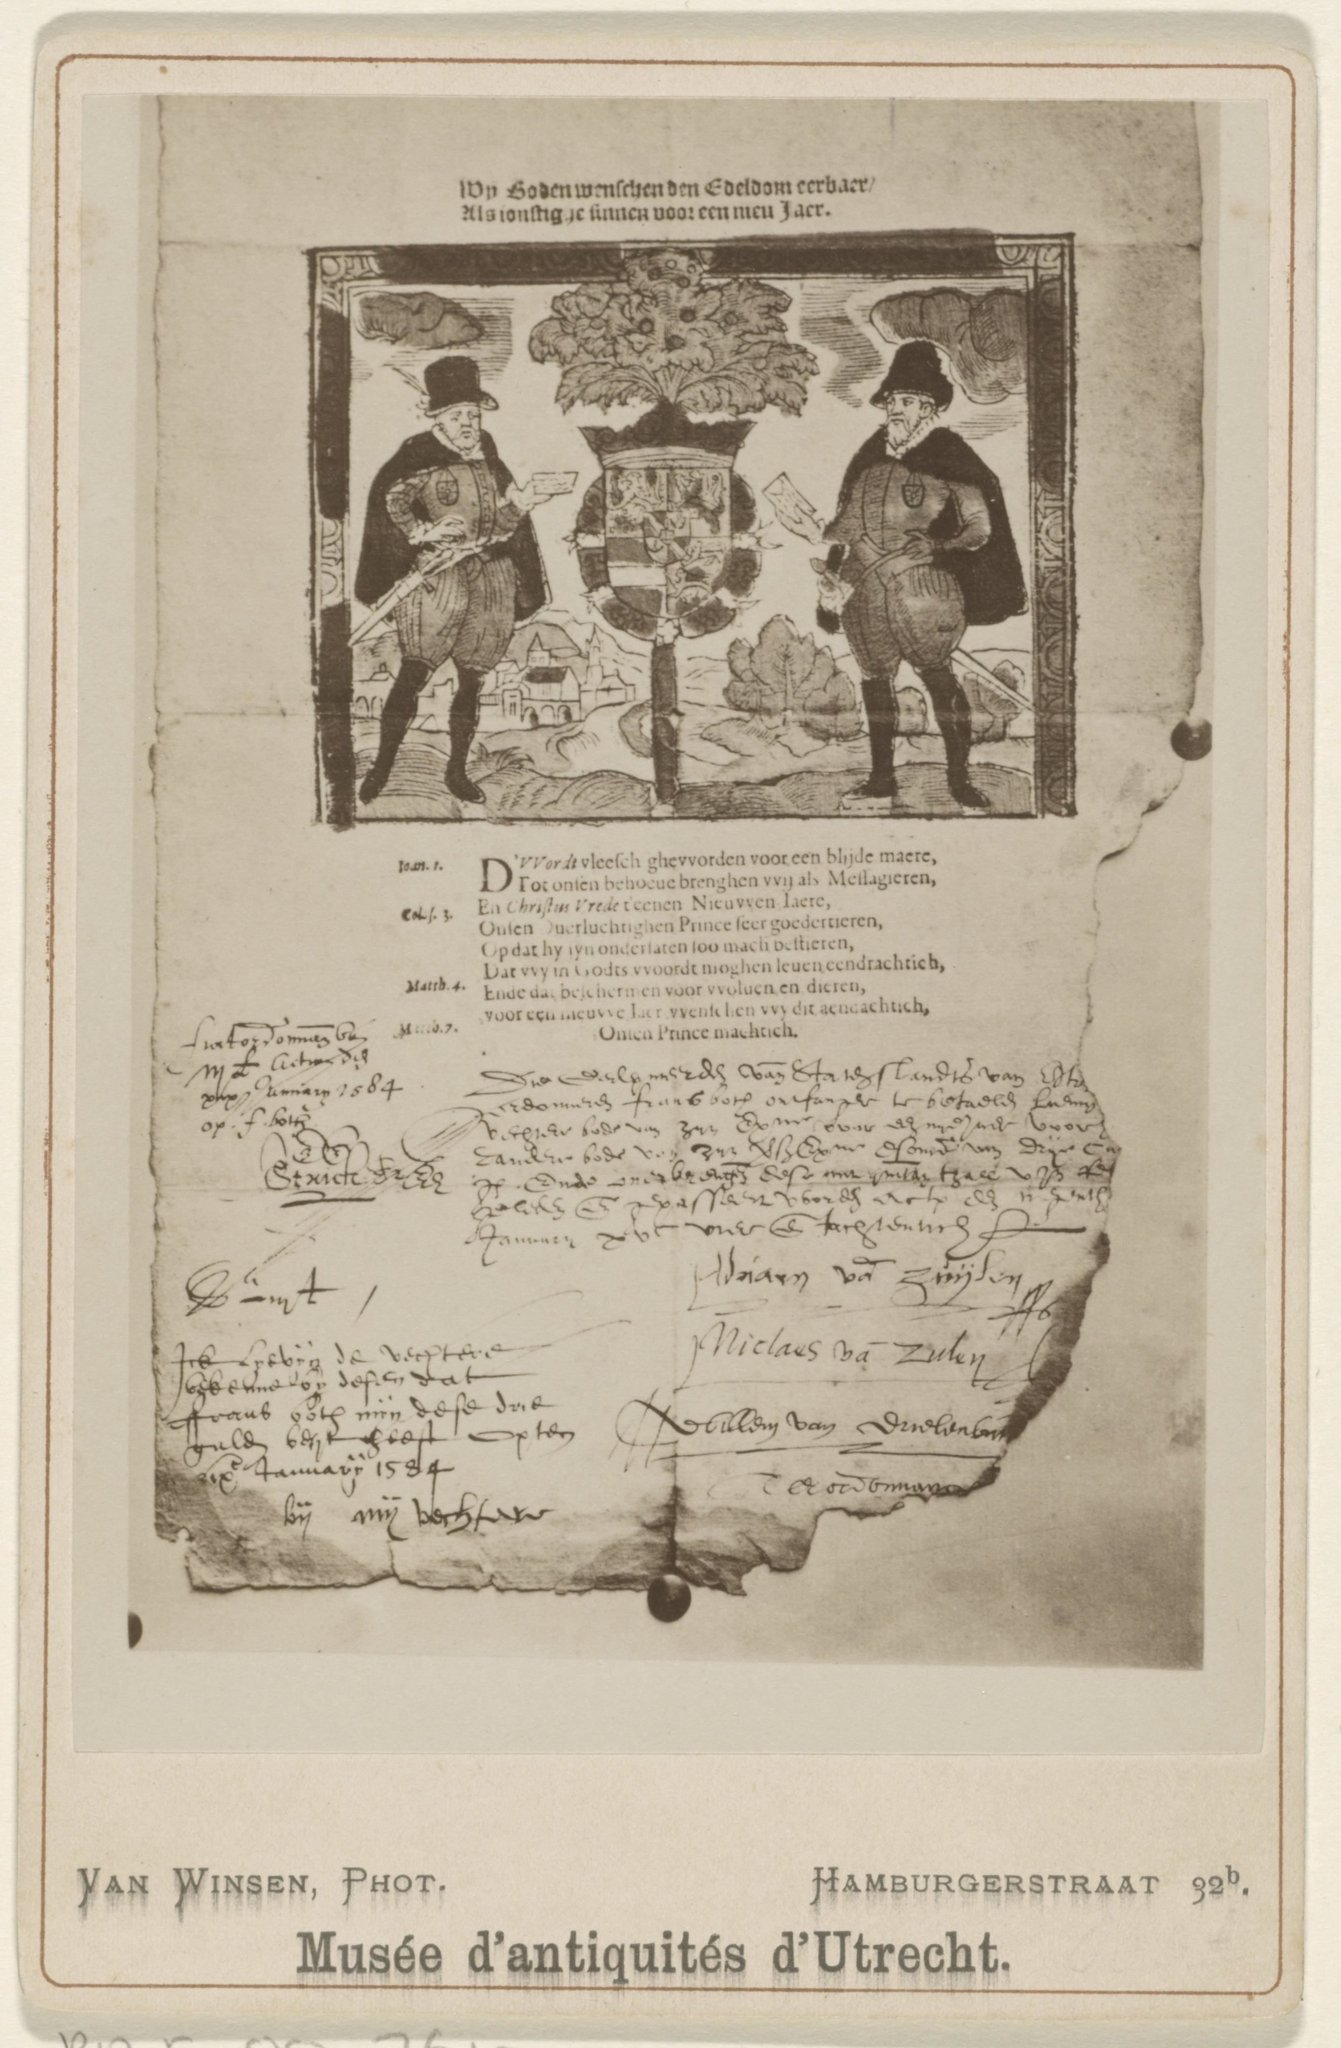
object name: new year card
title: Nieuwjaarswens van twee boden van Willem I, prins van Oranje, voor het jaar 1584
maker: jean jacques antoine van winsen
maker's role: fotograaf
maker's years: 1851-1927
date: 1861-1927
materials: cardboard, photographic support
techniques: photography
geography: utrecht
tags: delft, william i (prince of orange)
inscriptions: collector's mark: Lugt 2228, address: ‘Van Winsen, Phot. Hamburgerstraat 32b.’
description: Nieuwjaarswens van twee boden van Willem I voor het jaar 1584. Ze staan naast een oranjeboom met een wapen in een krans. Op de achtergrond een landschap en een stad. In de ondermarge negen regels Nederlandse tekst. Op de prent staat een handgeschreven verzoek van de kassier Frans Both aan Gedeputeerde Staten van Utrecht om drie gulden te betalen aan de bodes, welk verzoek nog dezelfde dag wordt gehonoreerd en ondertekend wordt door Adriaan van Zuylen, Nicolaas van Zuylen en Willem van Drielenburch. Daaronder verklaart Lieven de Vechter, een van de bodes, dat hij het geld heeft ontvangen.